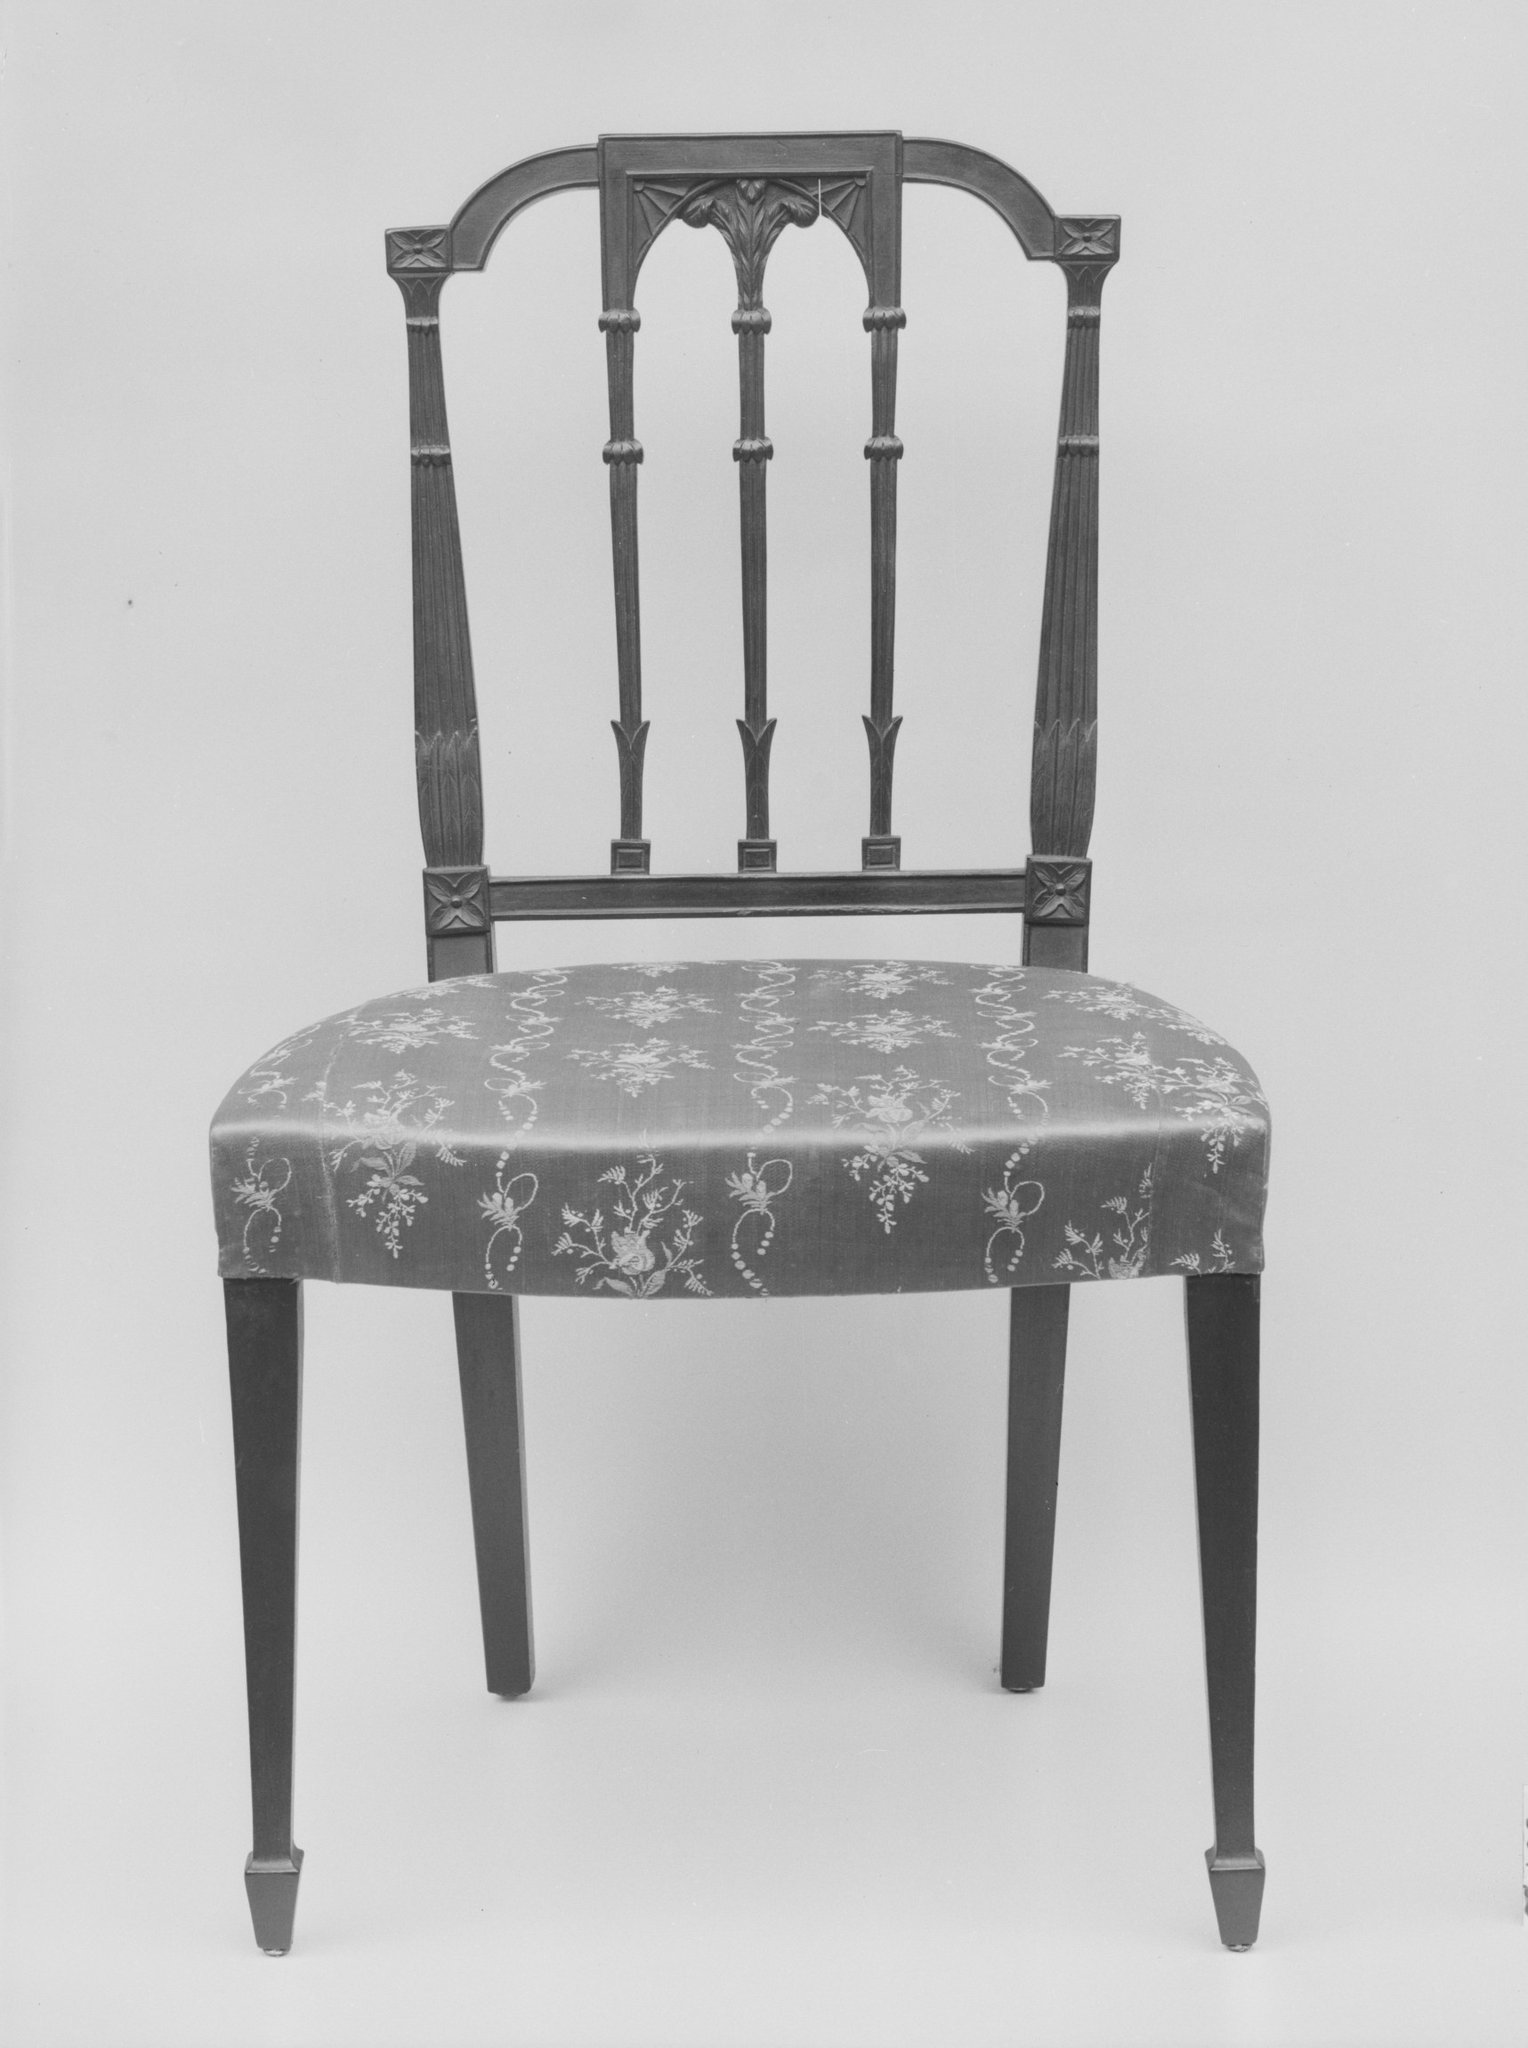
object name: side chair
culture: american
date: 1795-1810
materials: wood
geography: united states